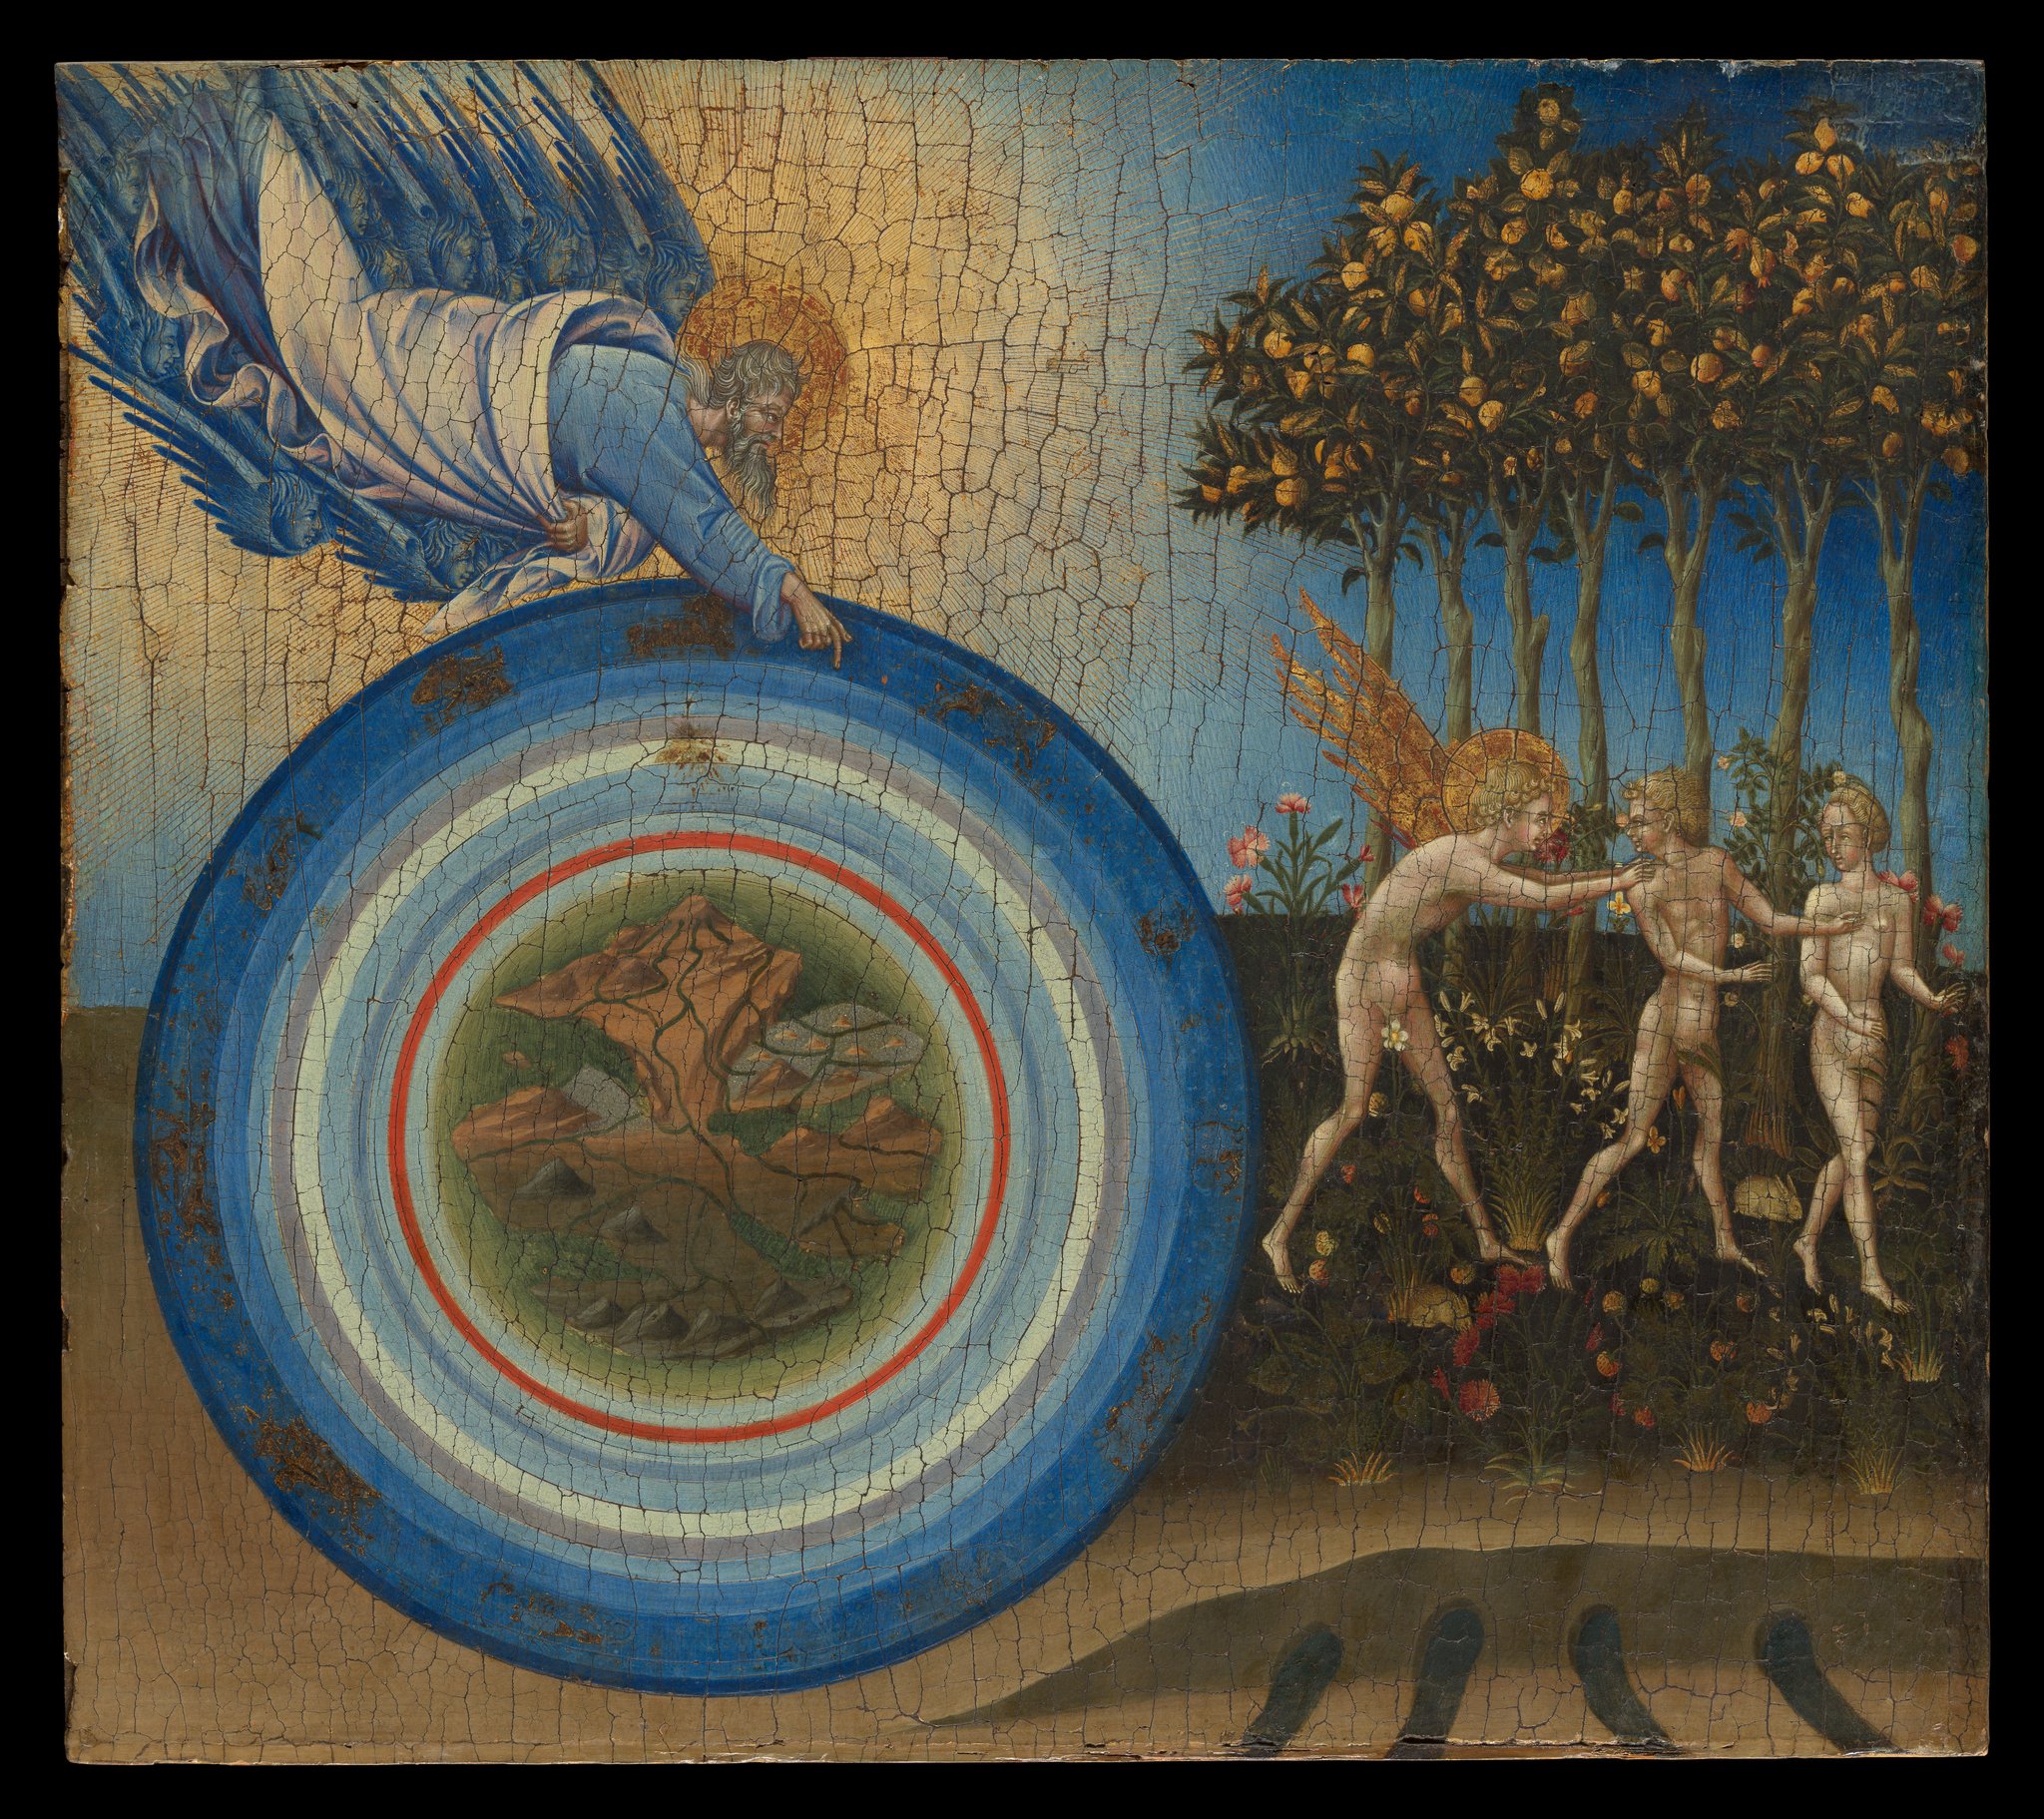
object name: painting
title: The Creation of the World and the Expulsion from Paradise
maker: giovanni di paolo (giovanni di paolo di grazia)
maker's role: artist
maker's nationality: italian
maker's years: 1398-1482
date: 1445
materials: gold, paint, wood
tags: angels,gods,adam,eve